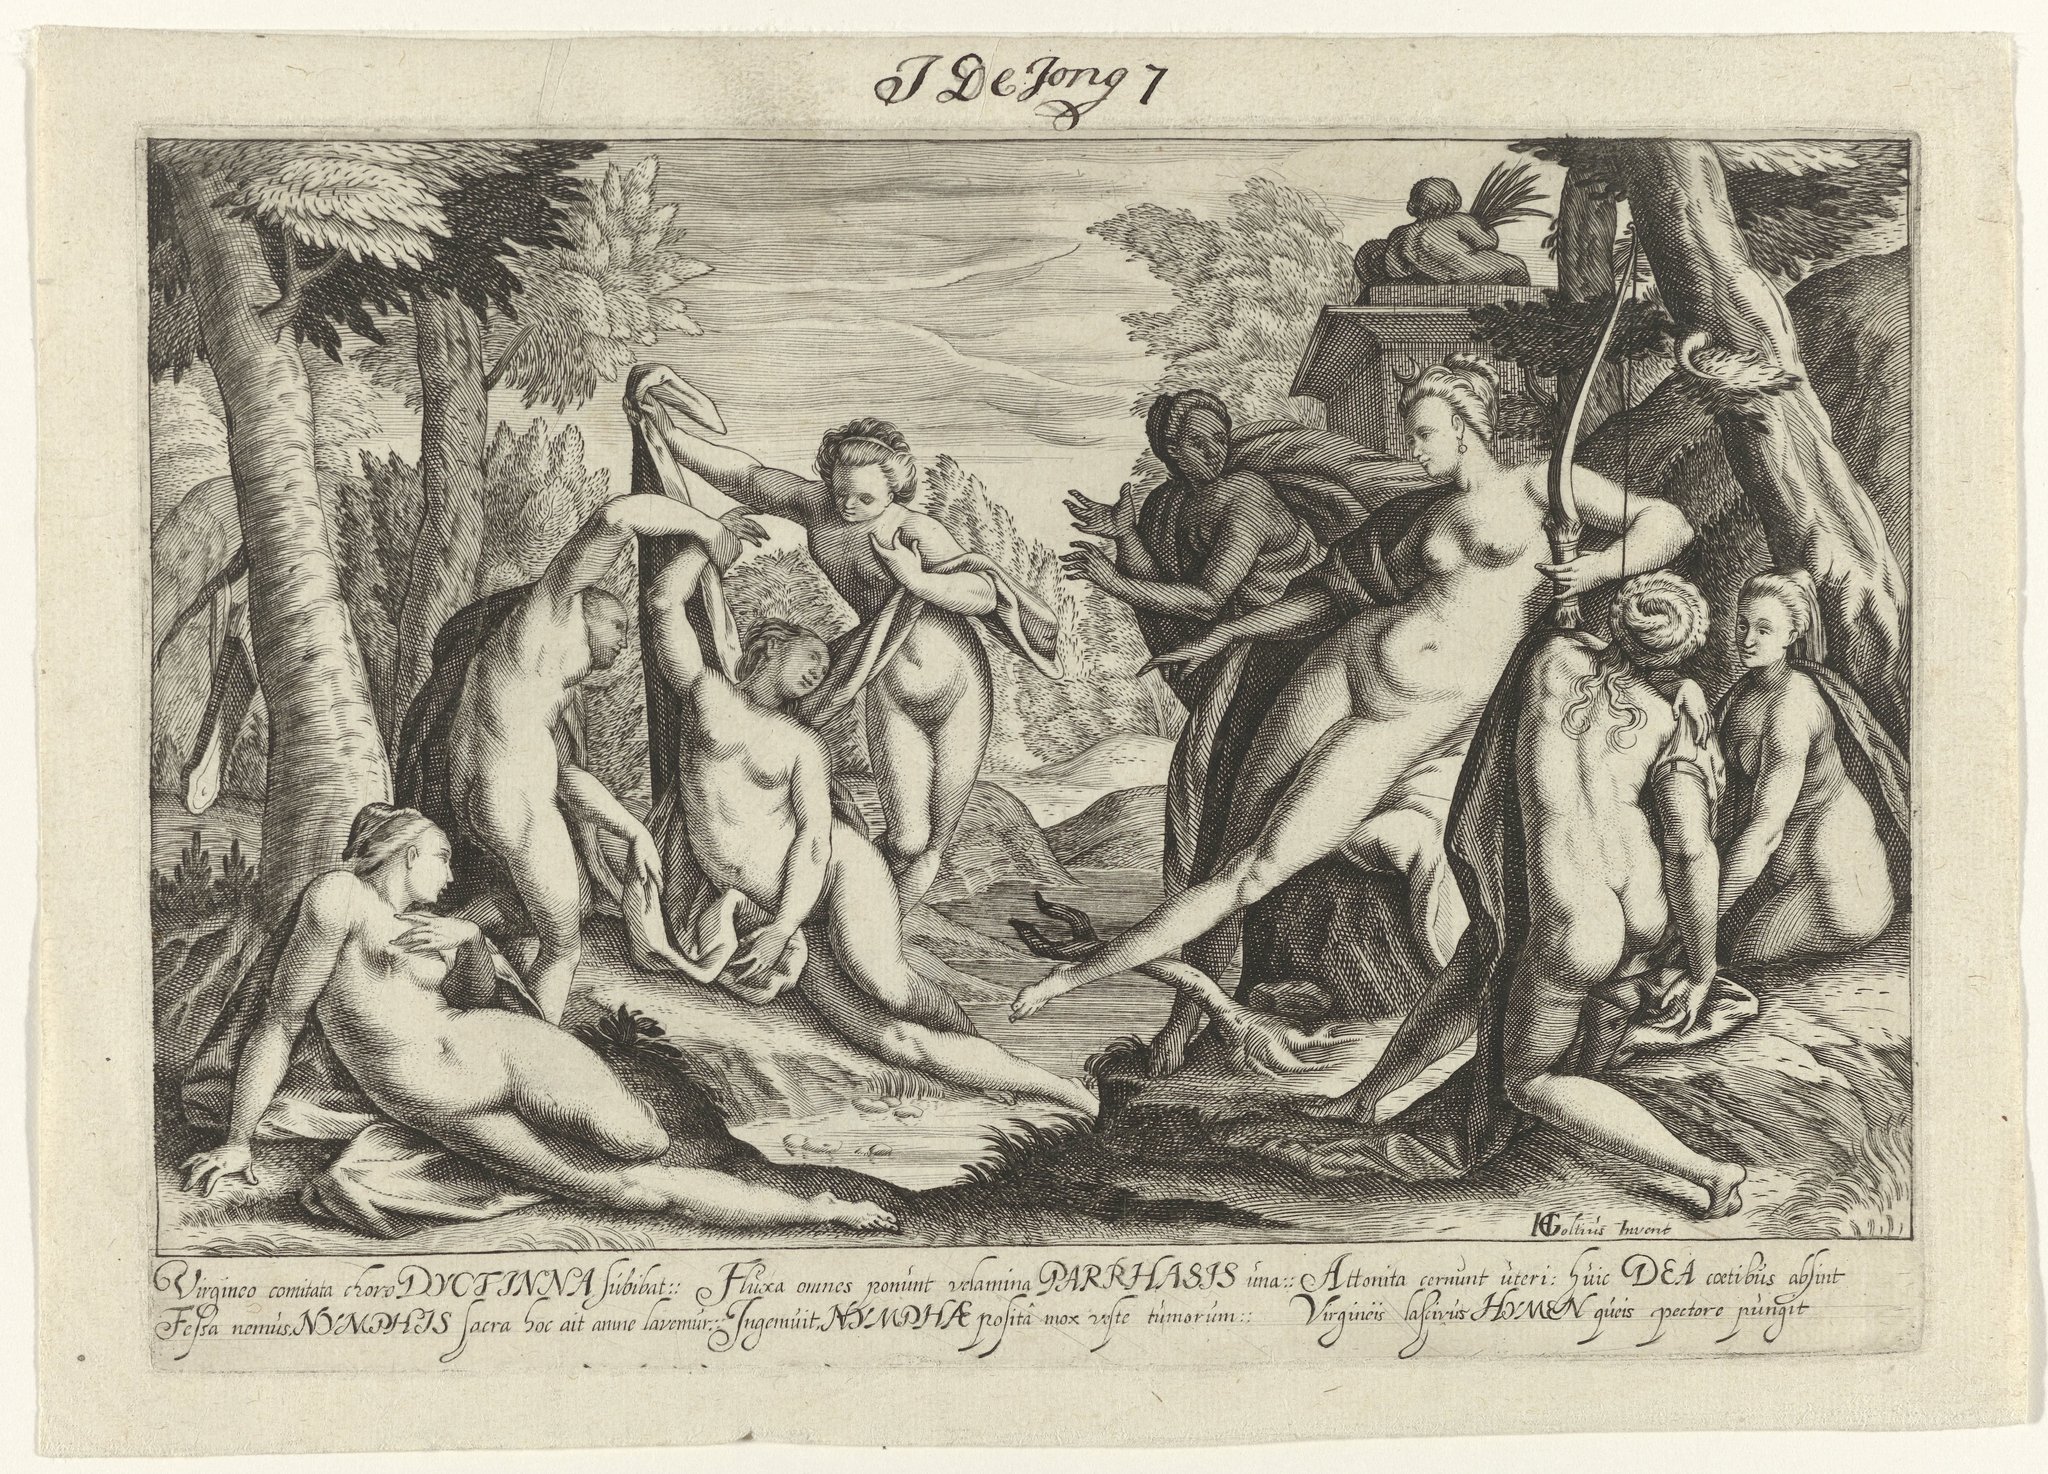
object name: print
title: Diana ontdekt de zwangerschap van Callisto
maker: Anonymous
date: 1573-1667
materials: paper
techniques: engraving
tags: diana with her nymphs discovers the pregnancy of callisto, pregnancy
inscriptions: collector's mark: Lugt 2228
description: De godin Diana met haar nimfen in het bos. Zij wijst beschuldigend naar Callisto, wiens kleding door de nimfen opzij wordt getrokken om haar zwangerschap te onthullen. Onder de voorstelling een tweeregelige tekst in het Latijn.